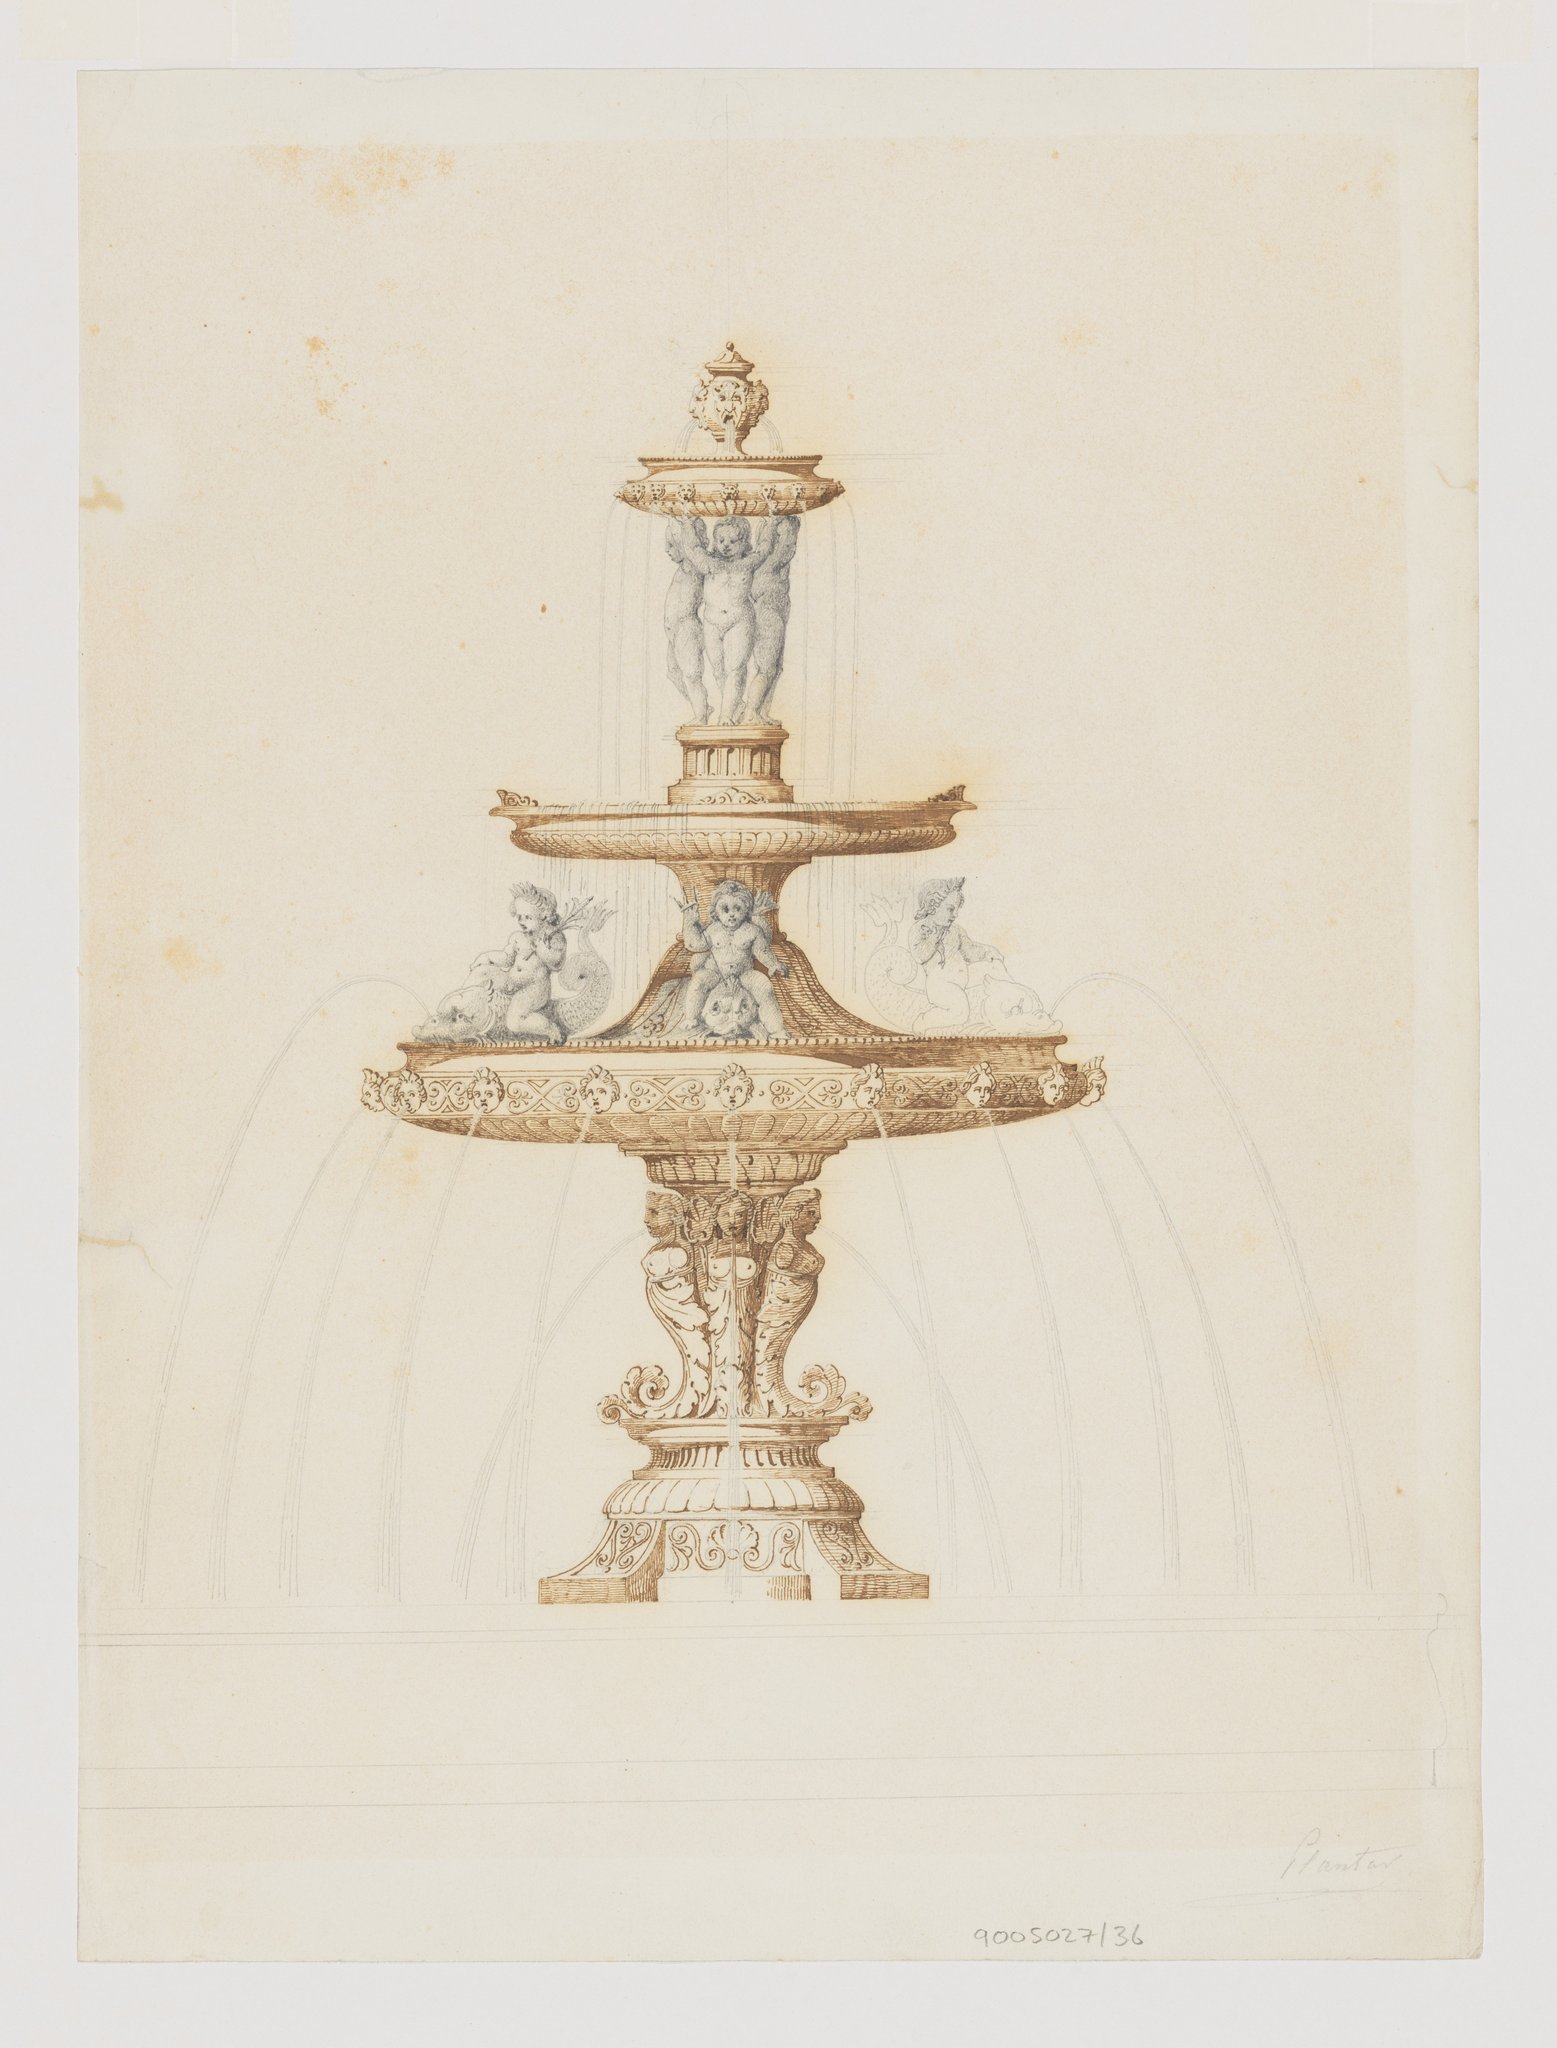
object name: drawing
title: Design for a Fountain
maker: jean-baptiste louis plantar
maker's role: artist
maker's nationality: french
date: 1834-1866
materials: graphite, ink, watercolor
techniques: pen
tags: fountains